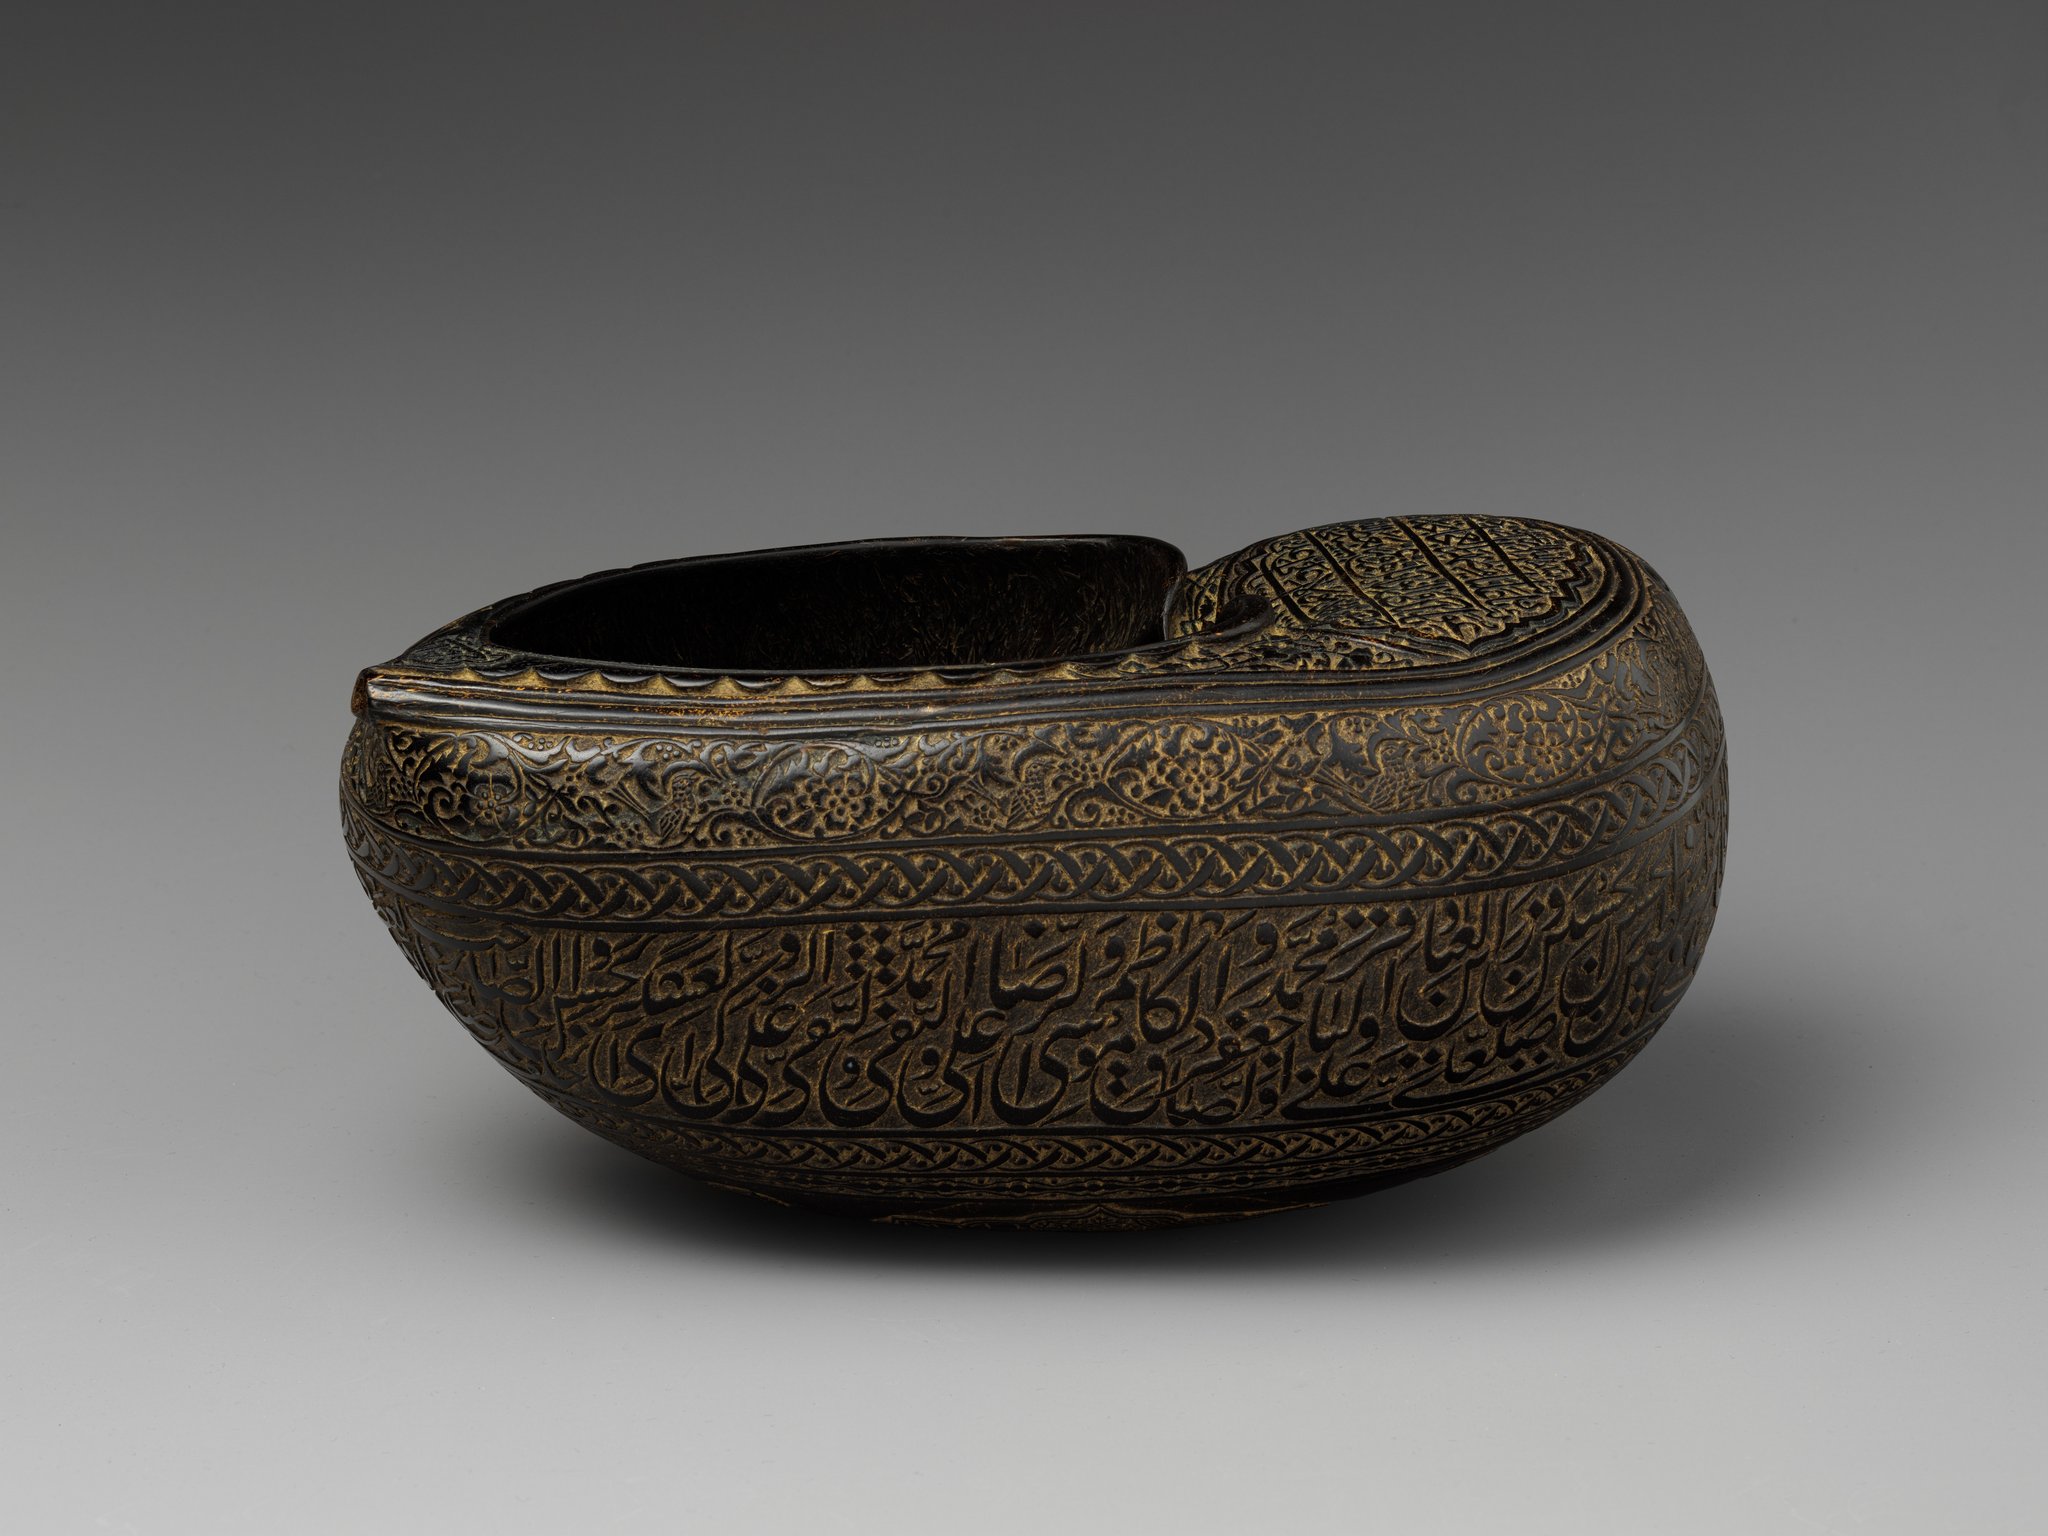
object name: beggar's bowl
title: Beggar's Bowl (Kashkul)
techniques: carving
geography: iran